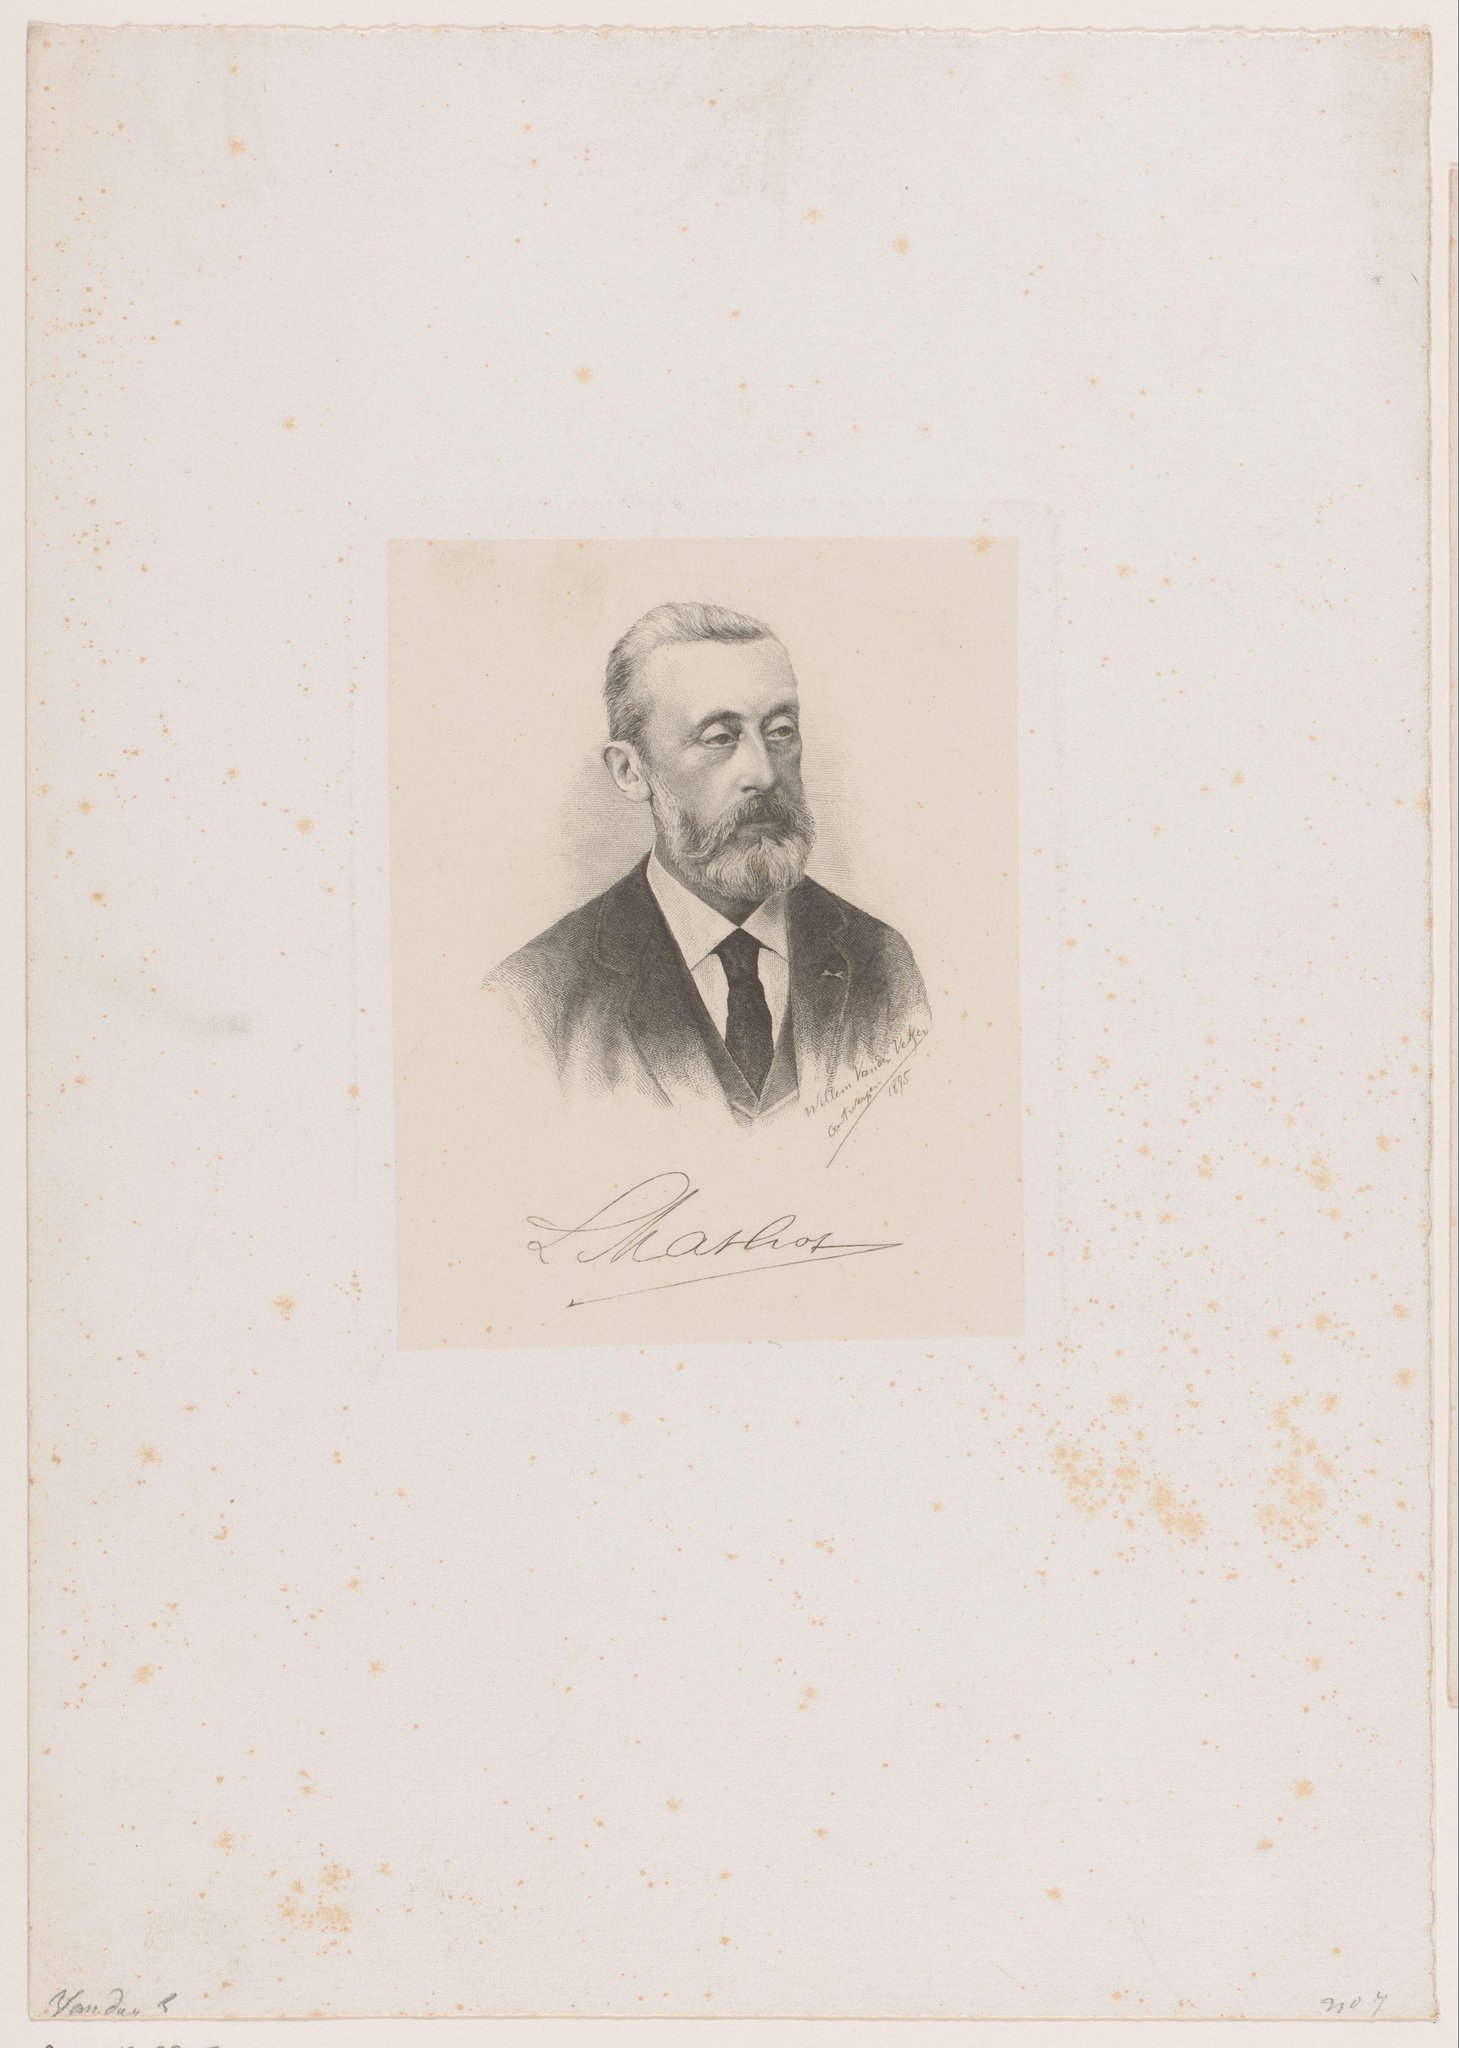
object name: print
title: Portret van L. Mathot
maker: willem philip van der veken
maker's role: print maker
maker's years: 1863-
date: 1895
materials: paper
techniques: etching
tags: adult man, historical persons, beard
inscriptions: collector's mark: Lugt 2228